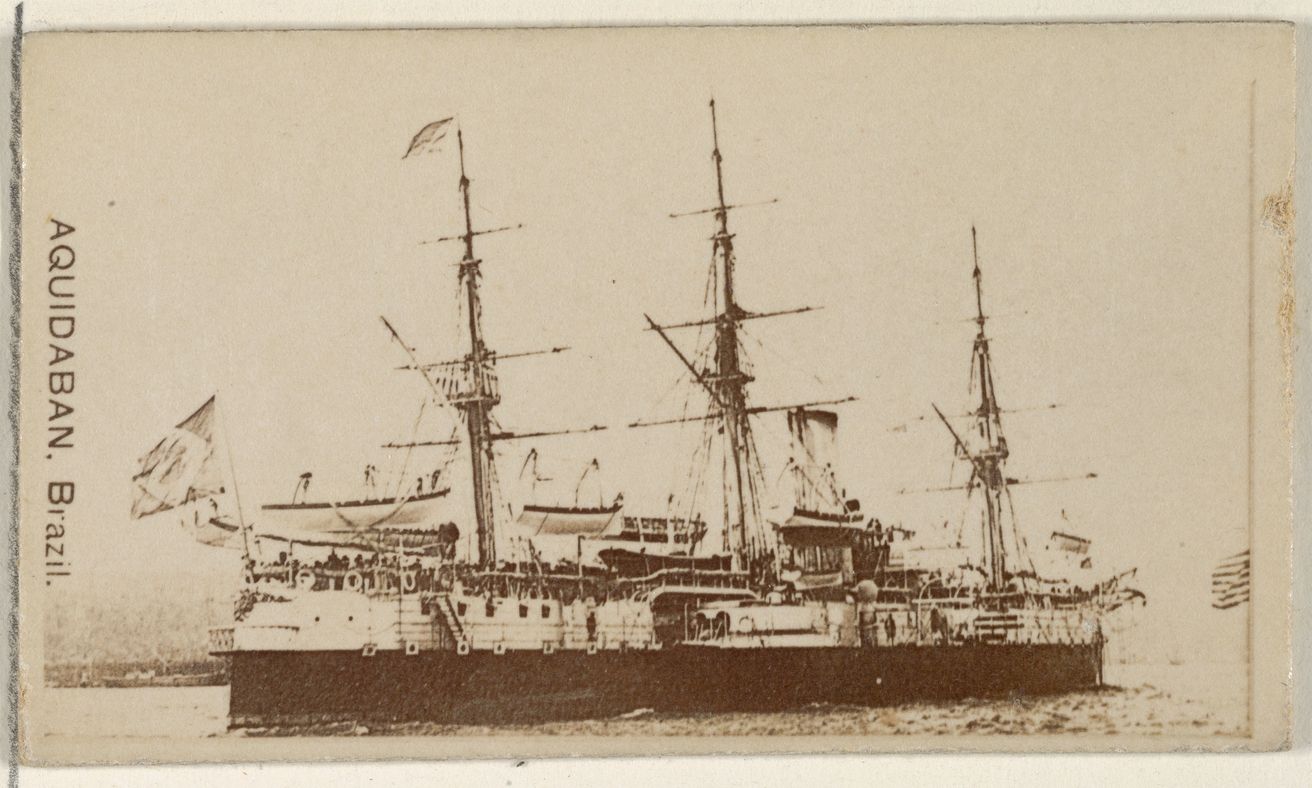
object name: photograph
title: Aquidaban, Brazil, from the Famous Ships series (N50) for Virginia Brights Cigarettes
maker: allen & ginter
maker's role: publisher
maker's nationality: american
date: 1895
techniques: albumen silver print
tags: ships